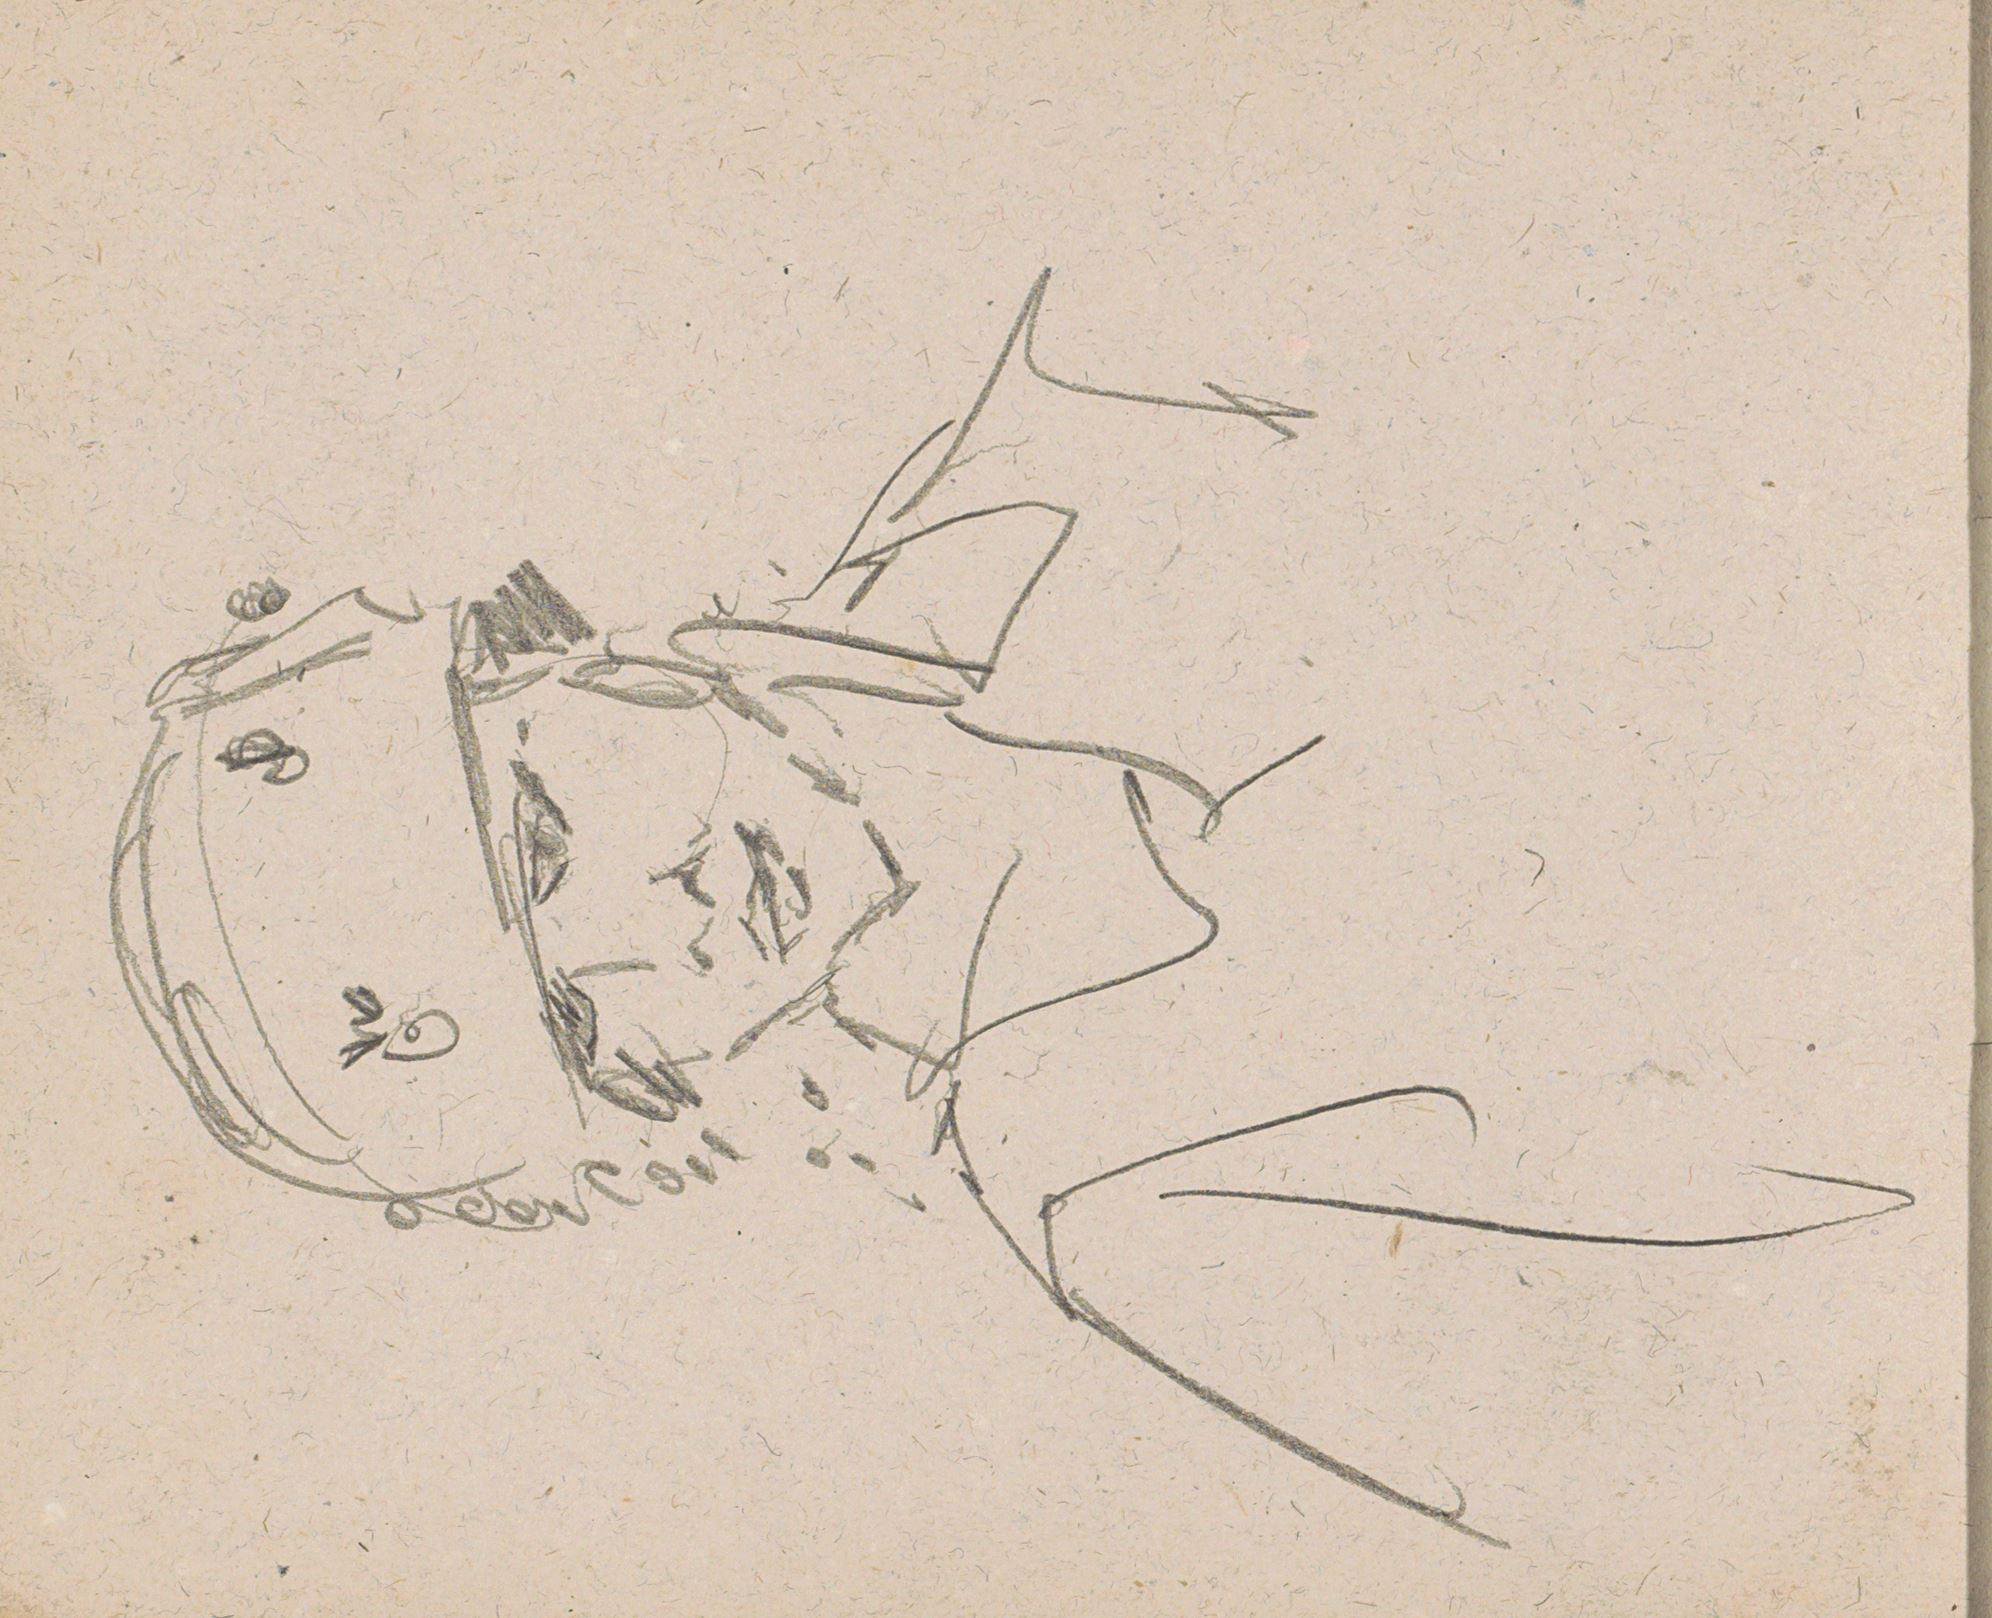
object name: sketchbook leaf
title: Vrouw met hoed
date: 1919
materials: paper, pencil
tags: adult woman, head-gear: hat (+ women's clothes)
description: Pagina 13 uit schetsboek XXXV met 36 pagina's.